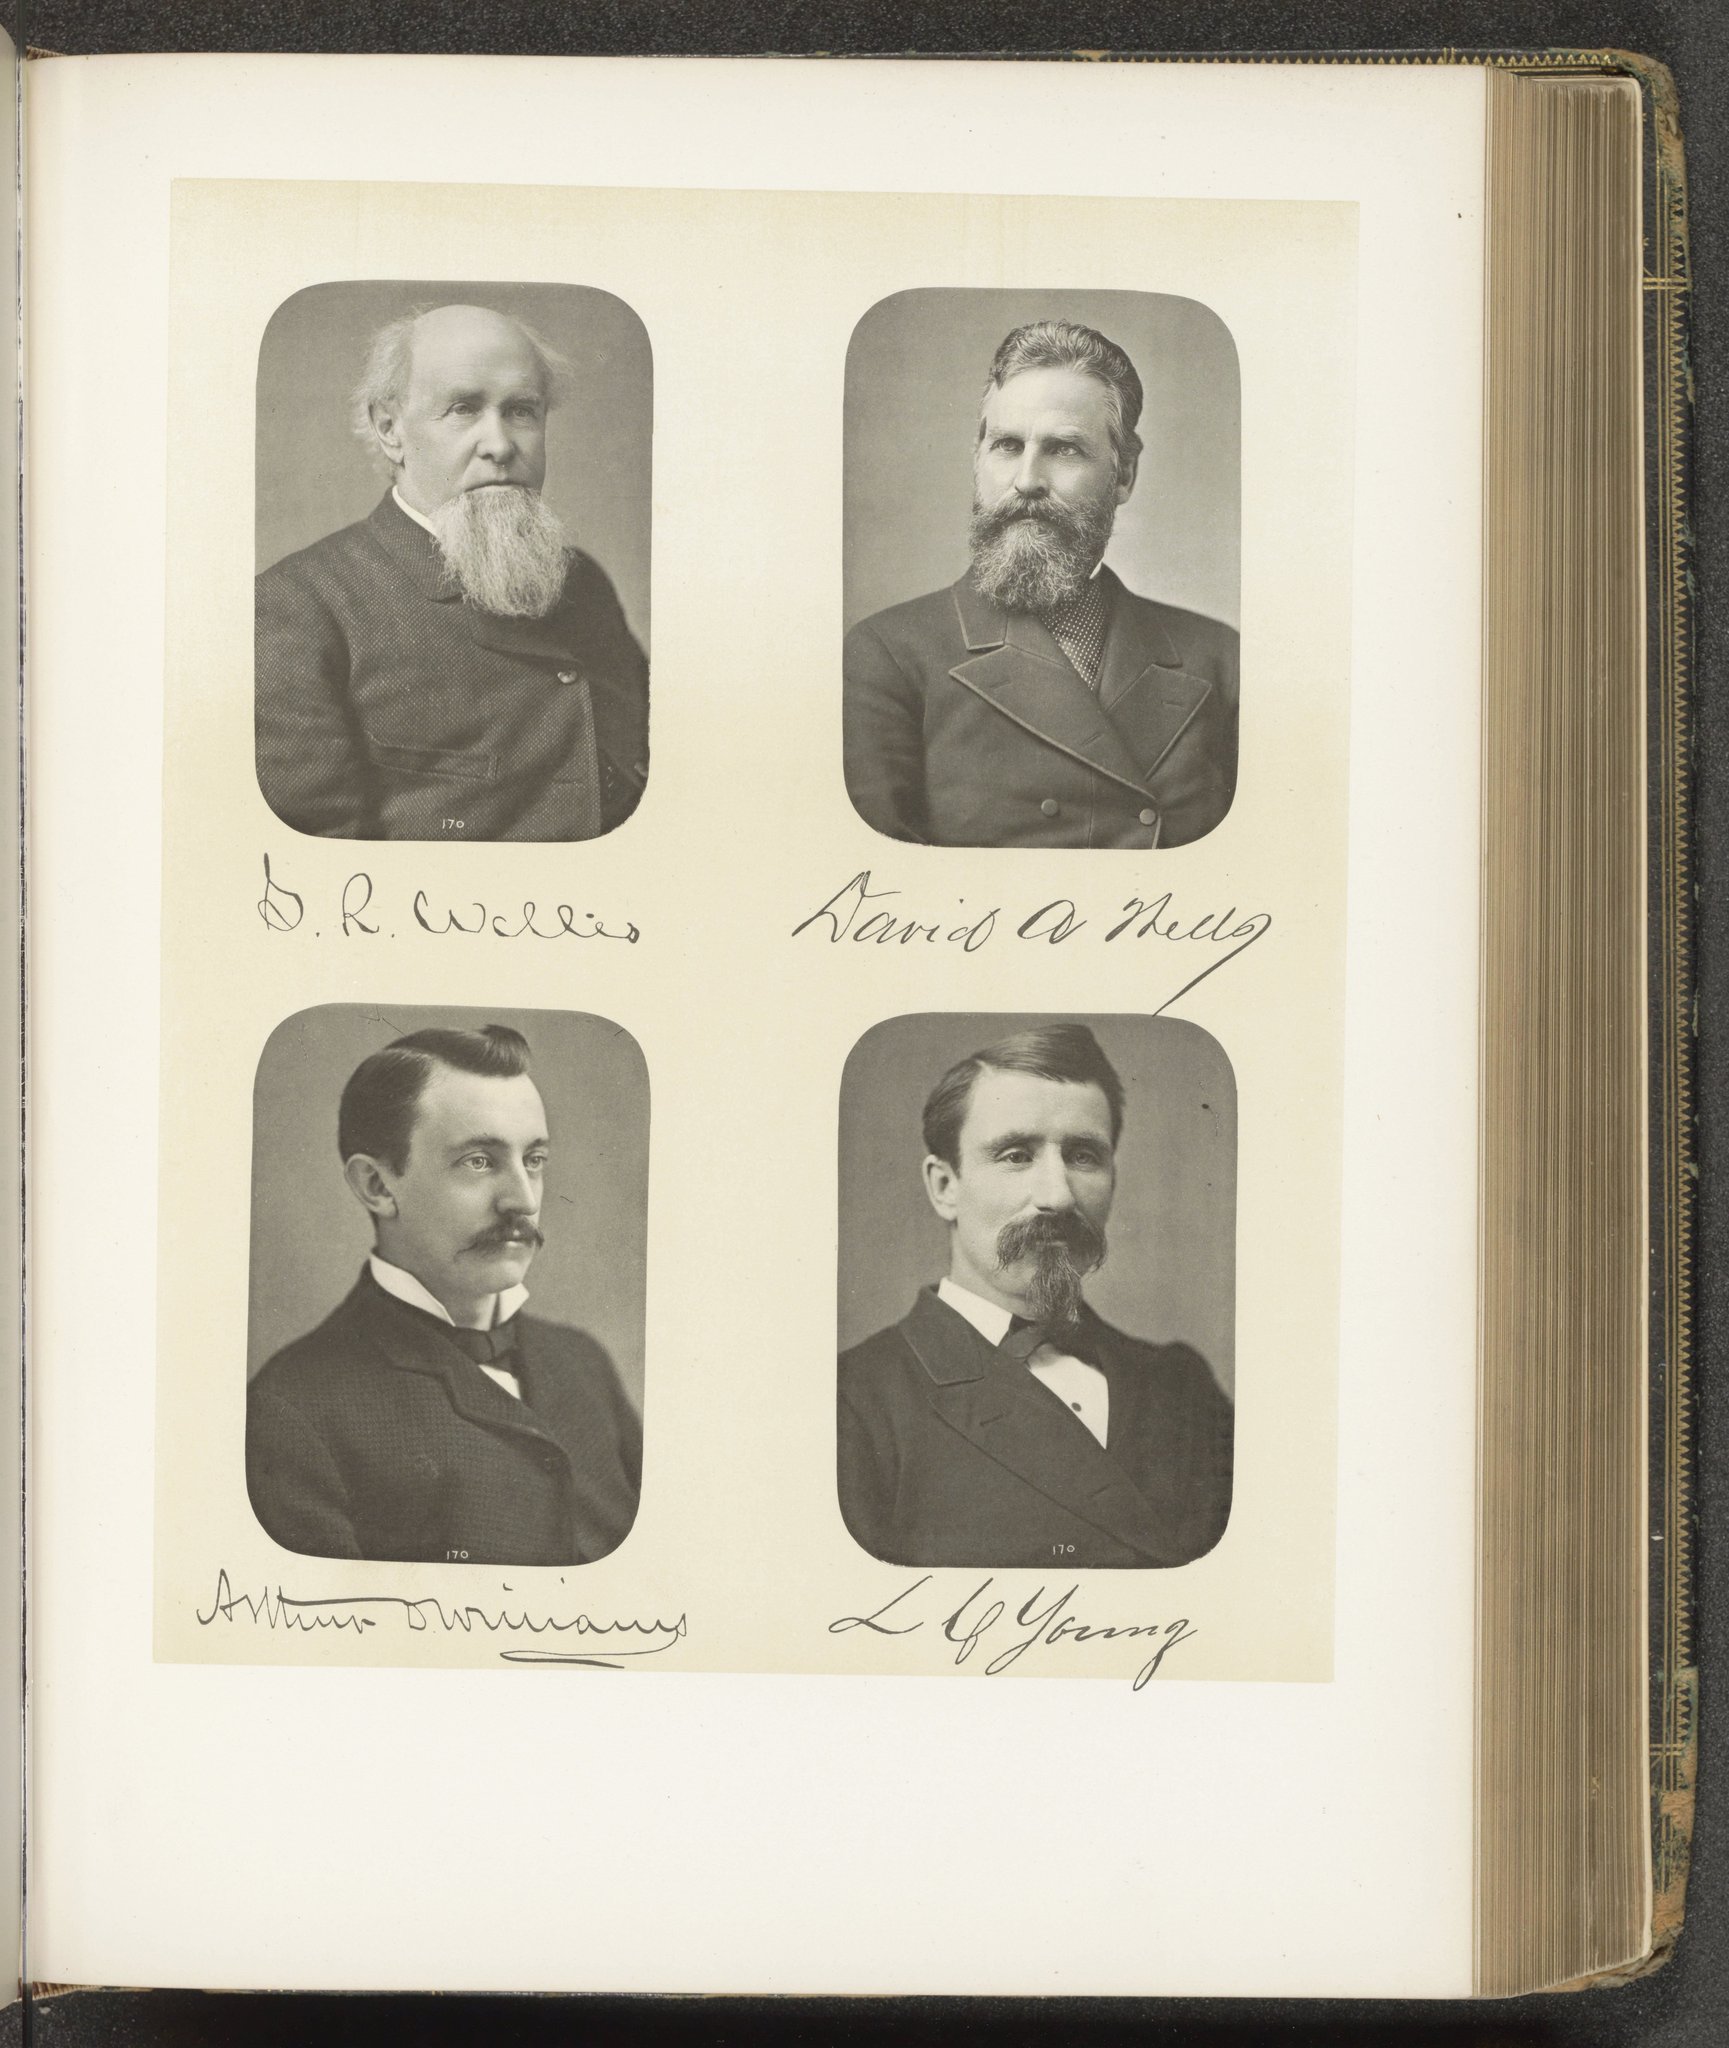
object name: photomechanical print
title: Portretten van vier leden van het Lagerhuis van de staat New York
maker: Anonymous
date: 1872-1882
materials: paper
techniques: photograph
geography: united states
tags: historical persons (portraits and scenes from the life) (+ head (and shoulders) (portrait))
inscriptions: annotation, number: ‘169’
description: Linksboven Hector H. Tuthill, rechtsboven Russell M. Tuttle, linksonder Cornelius van Buren, rechtsonder William H. Waring.